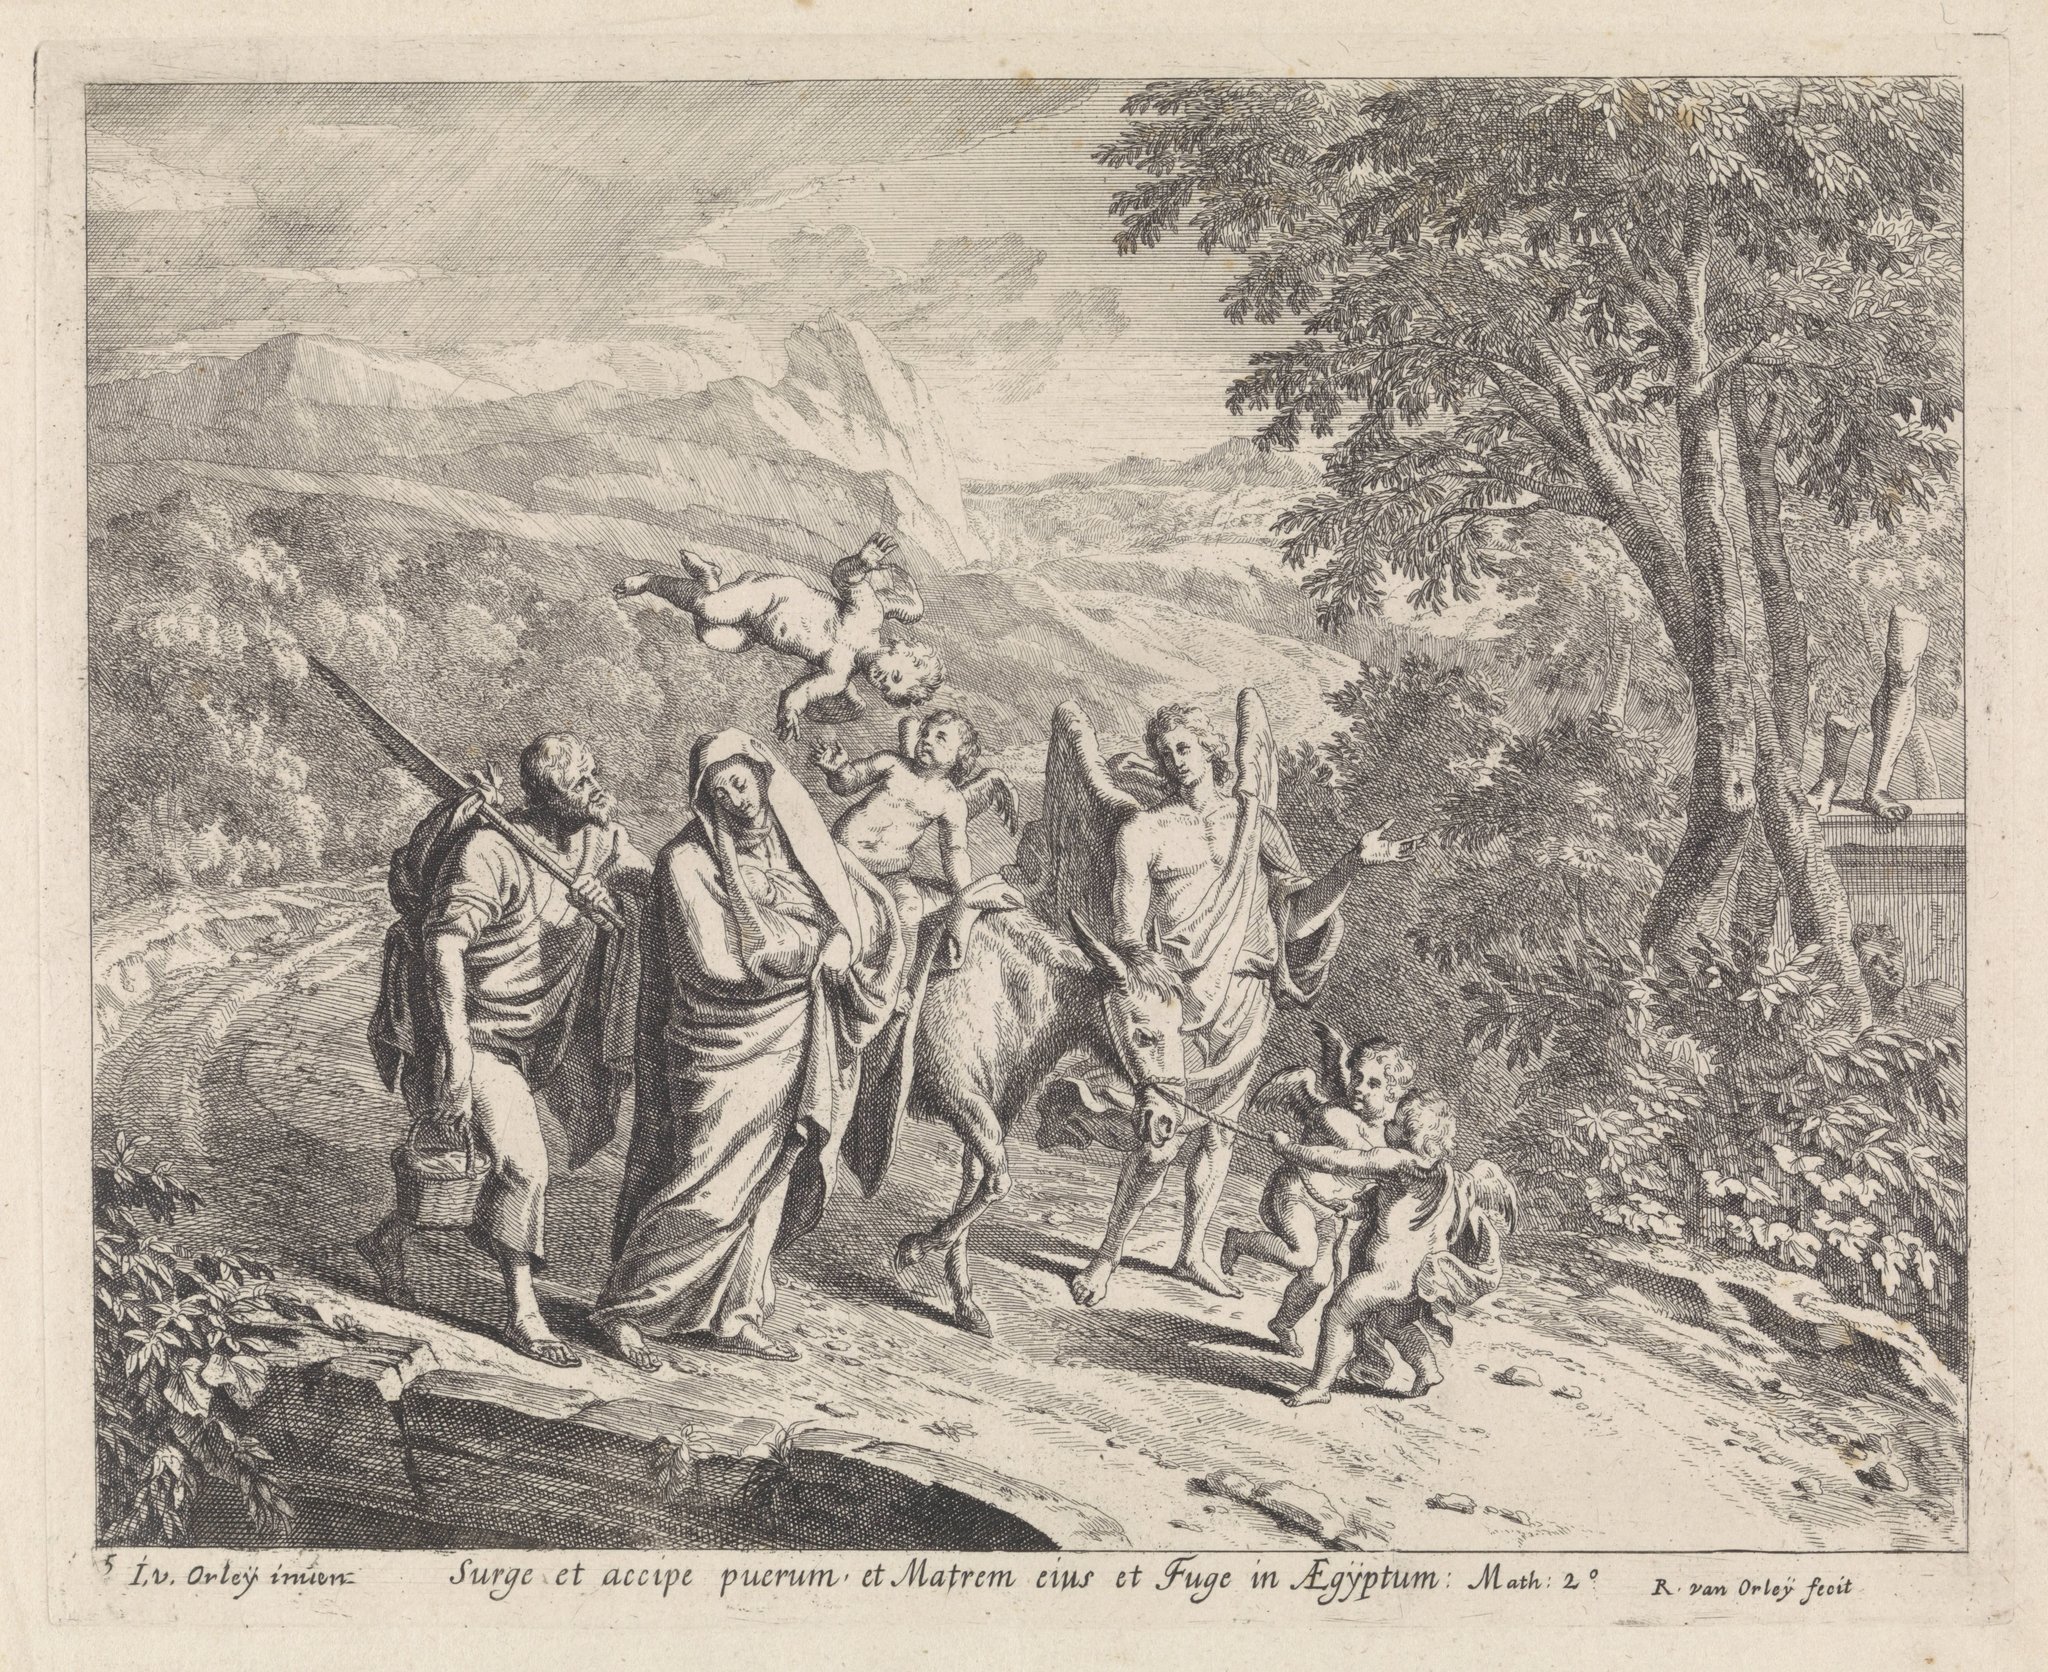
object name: print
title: Scènes uit het Nieuwe Testament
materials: paper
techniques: engraving, etching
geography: brussels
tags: the flight into egypt: mary, joseph, the child (and sometimes others) on their way; mary usually riding on an ass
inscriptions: collector's mark: Lugt 240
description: De Heilige Familie op de vlucht naar Egypte. Maria en Jozef lopen naast de ezel die door engelen getrokken wordt. Maria draagt Christus in een omslagdoek. Onder de afbeelding een Latijns vers uit Mat. 2.